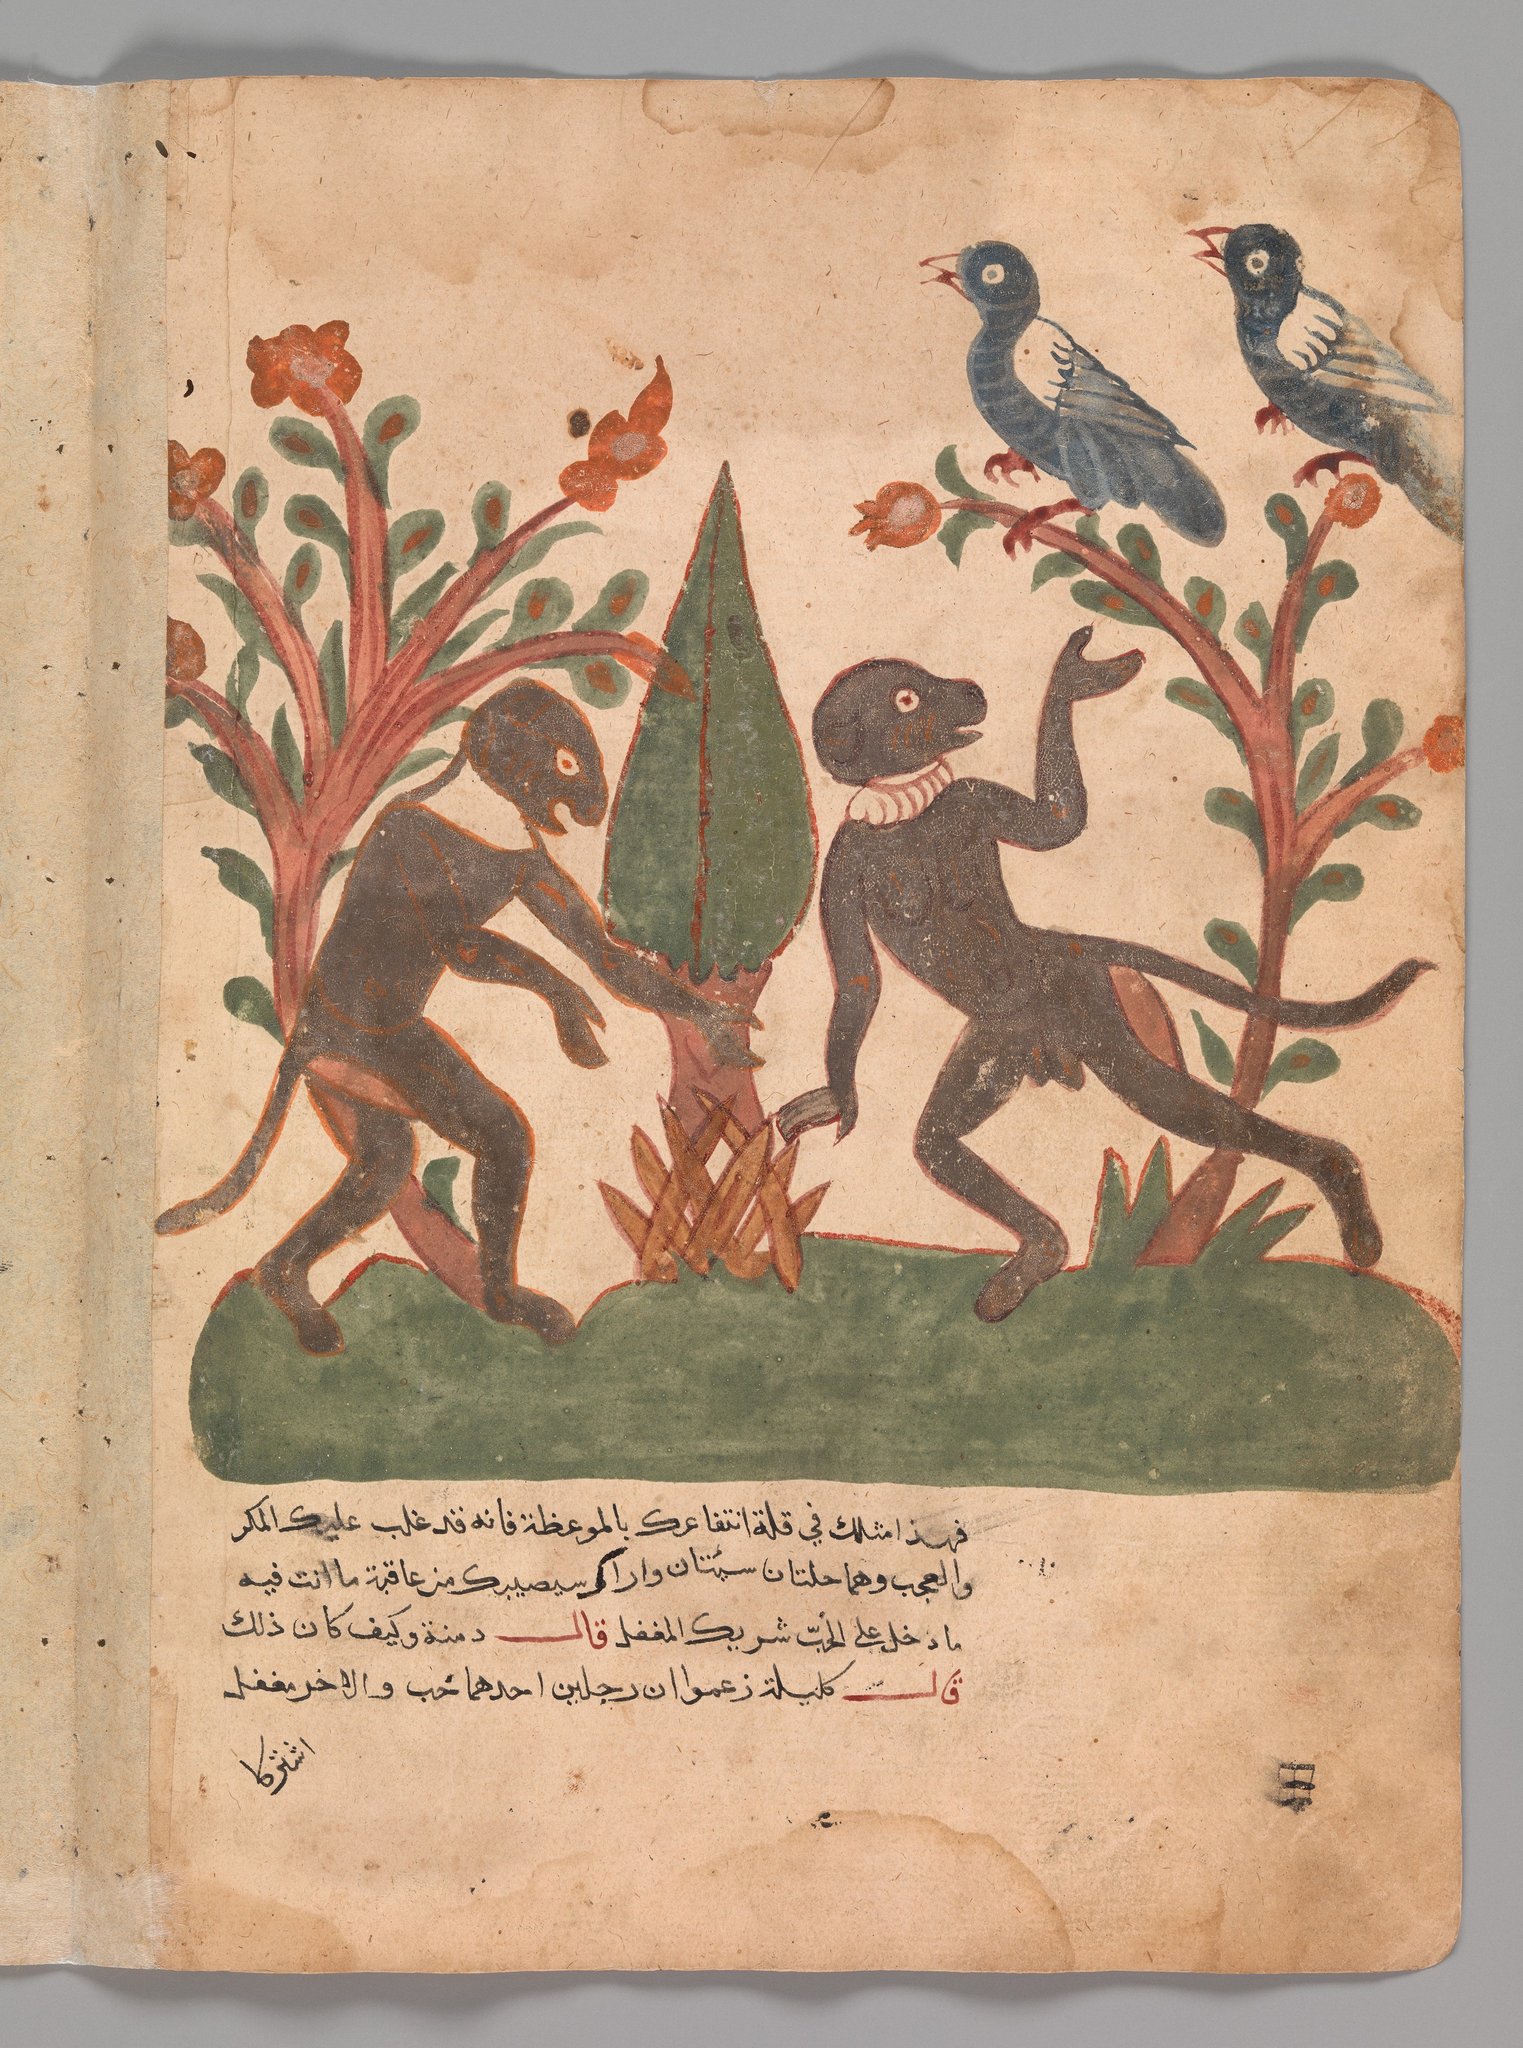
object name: folio from an illustrated manuscript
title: "The Birds and the Monkeys with the Glow Worm", Folio from a Kalila wa Dimna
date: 1526-1550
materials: ink, paper, watercolor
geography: india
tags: birds,monkeys,plants